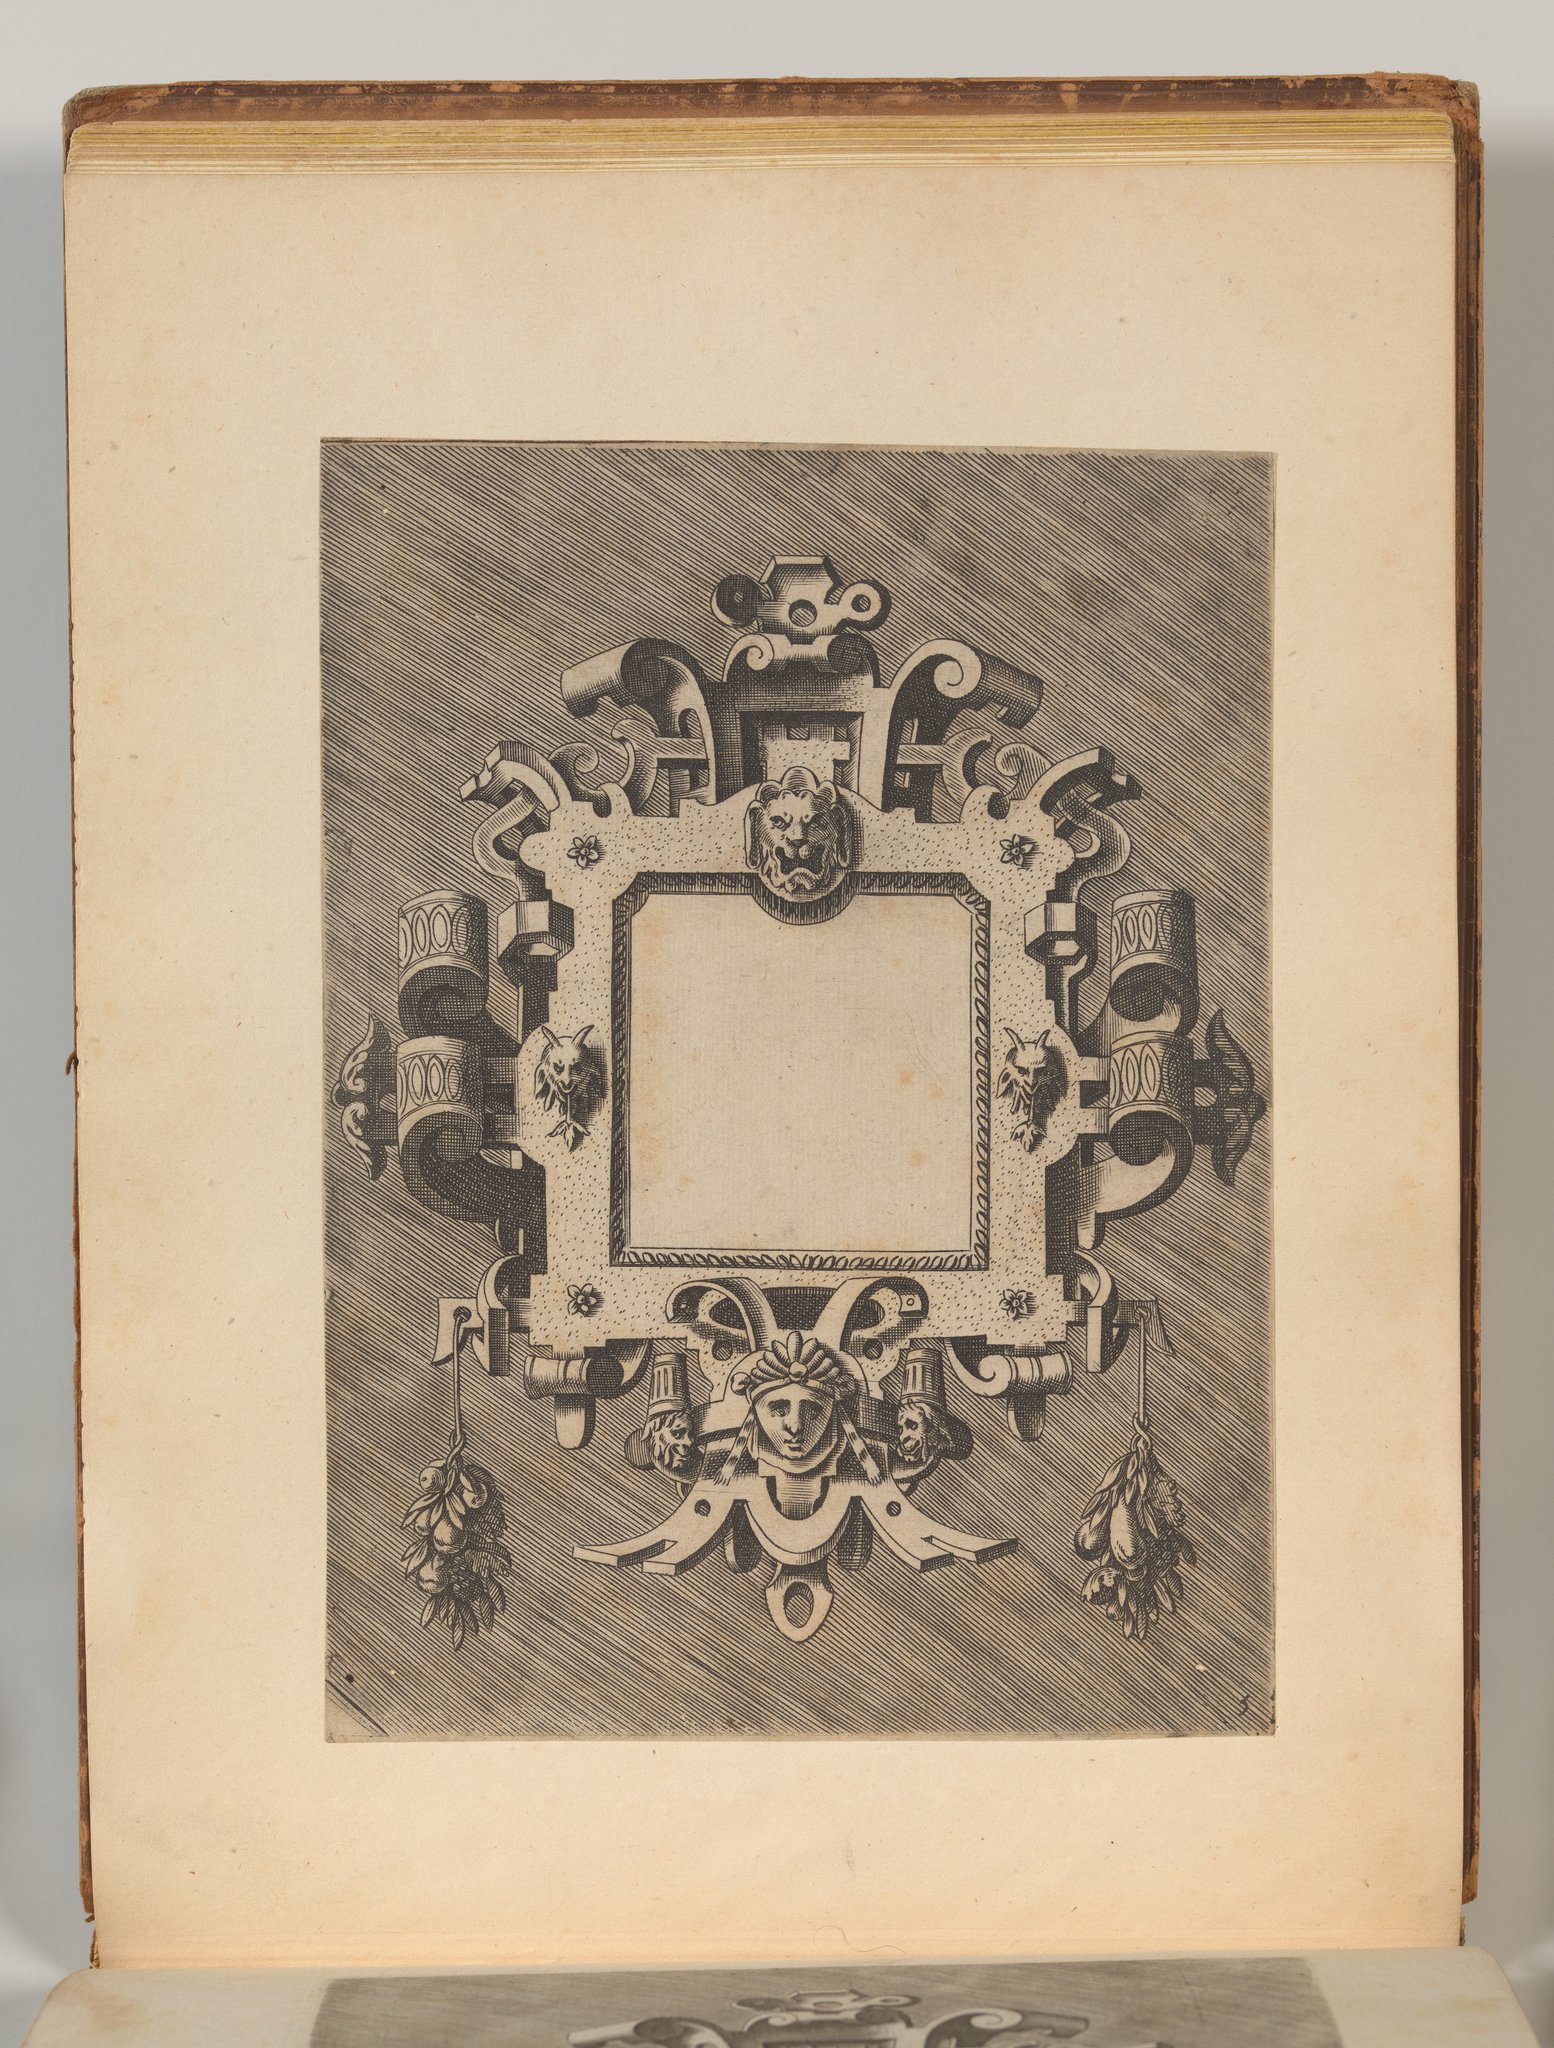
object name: album print ornament architecture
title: Targhe ed altri ornati di varie e capricciose invenzioni (Cartouches and other ornaments of various and capricious invention, page 30)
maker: hans vredeman de vries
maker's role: artist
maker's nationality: netherlandish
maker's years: 1527-1606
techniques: engraving, etching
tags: cartouches,faces,lions